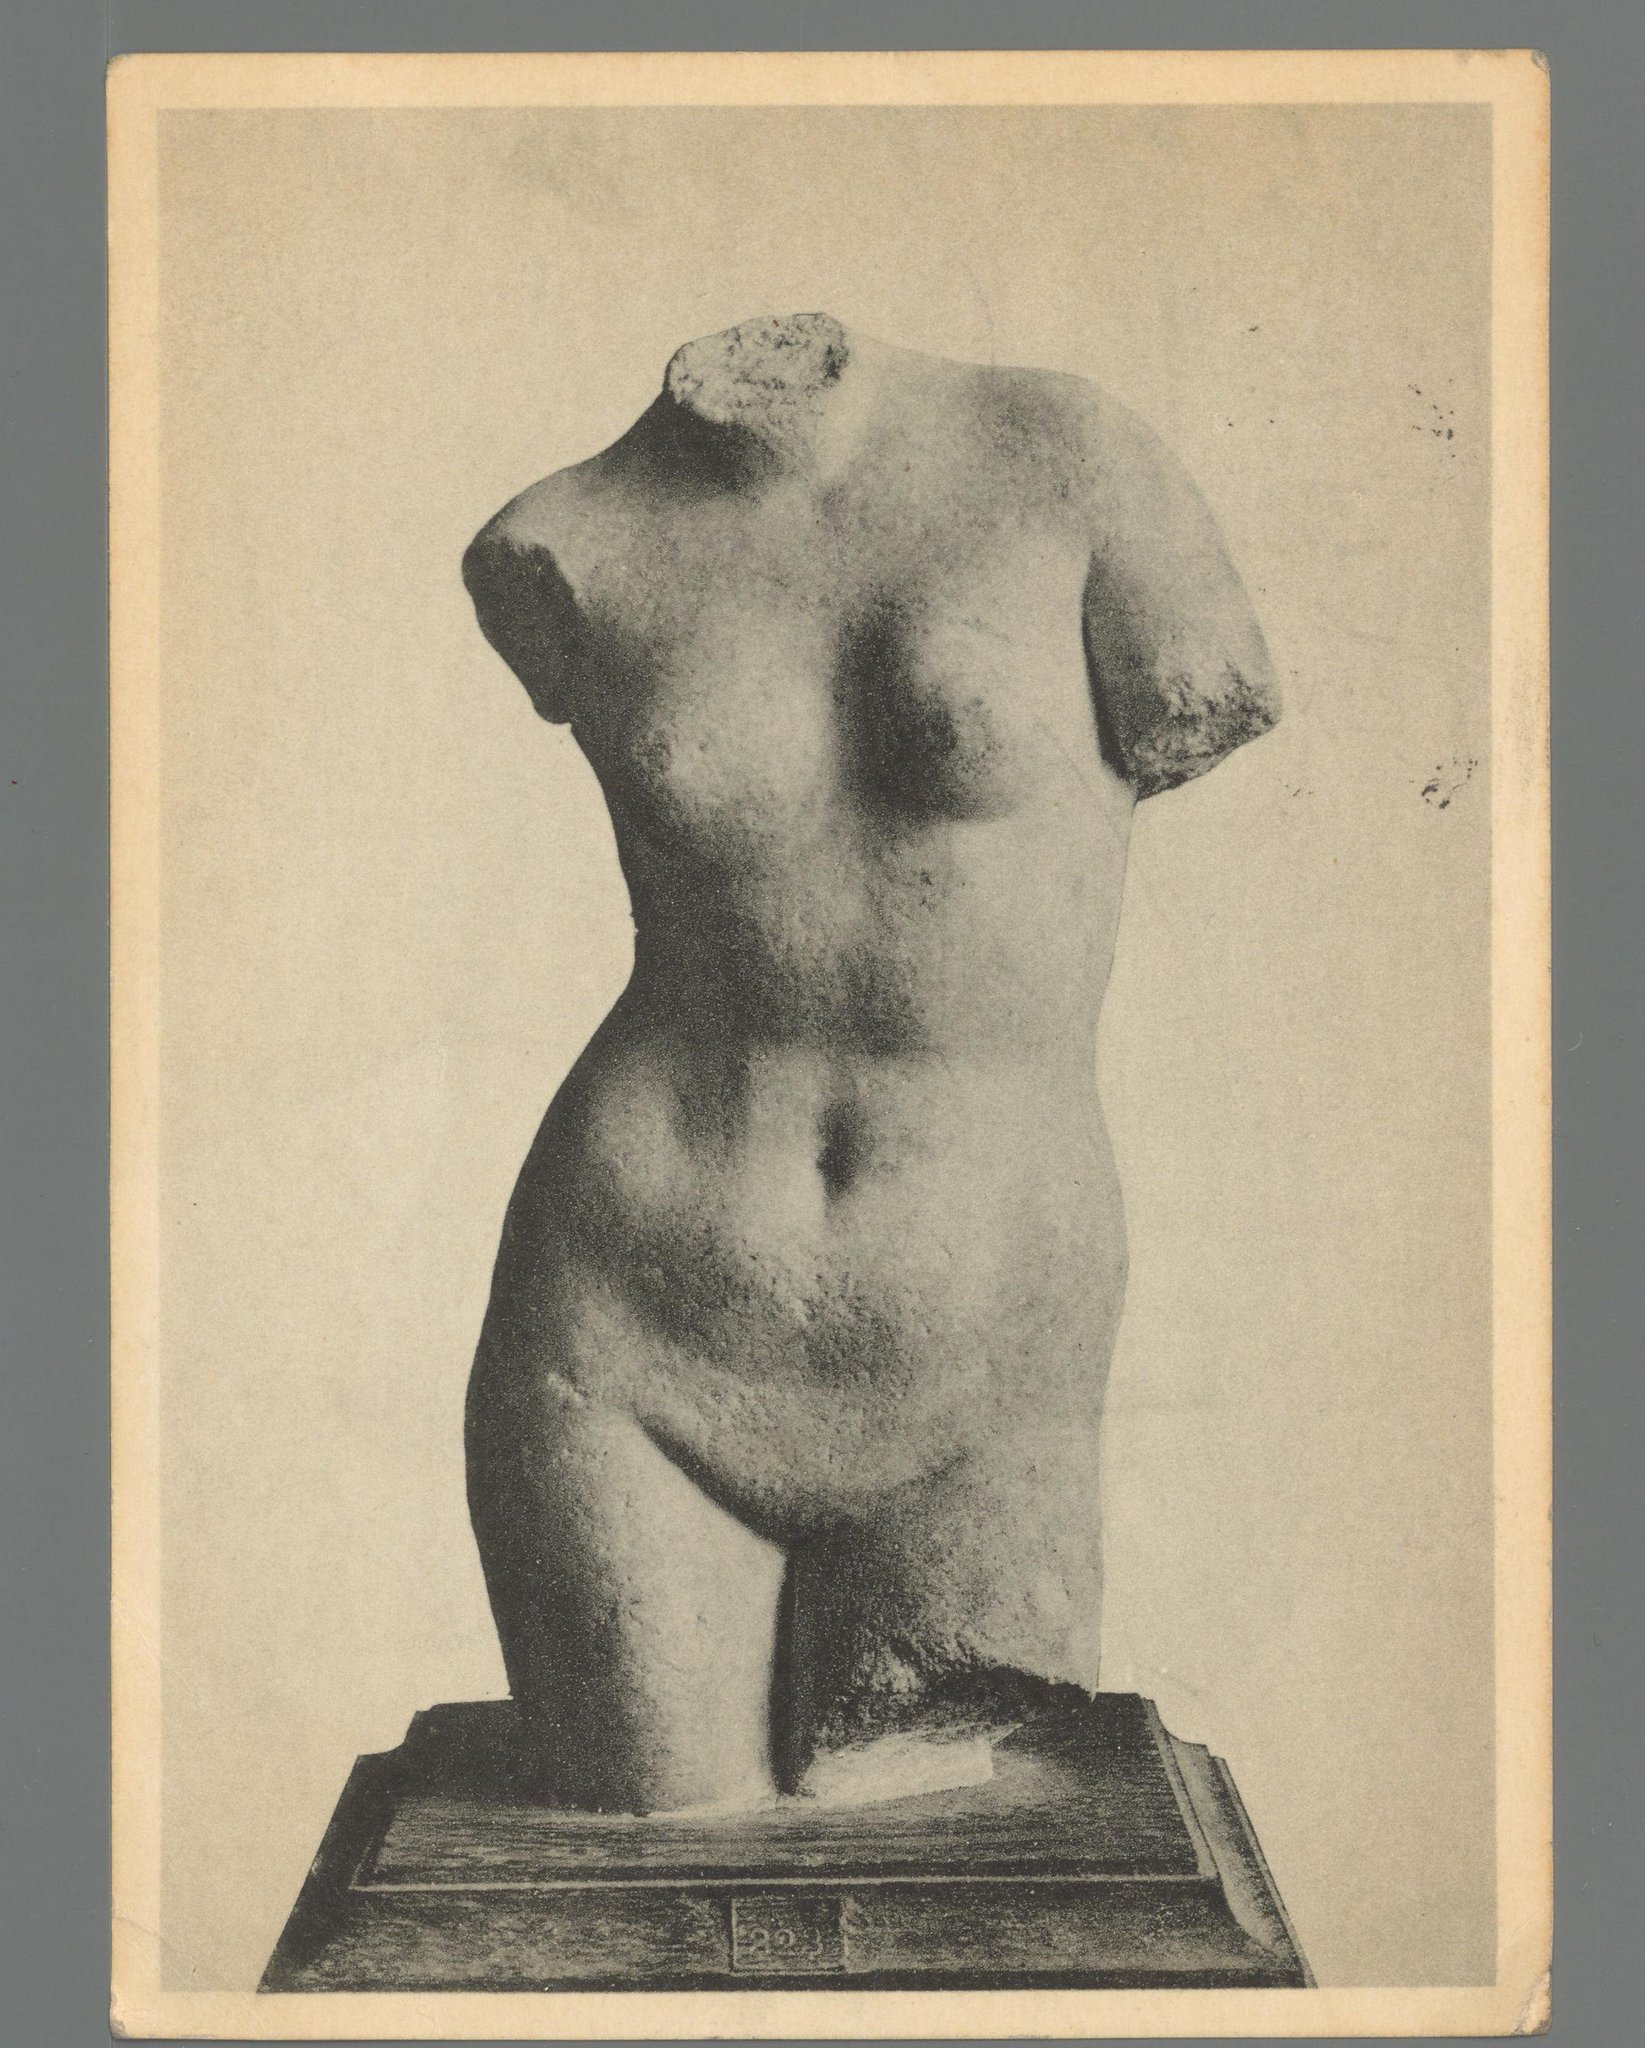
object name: photomechanical print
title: Musée de Mariemont. Torse d'Aphrodite. Epoque Hellénistique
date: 1917-1946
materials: cardboard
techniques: photograph, writing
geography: brussels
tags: statues, paintings, etc. ~ objects of worship in roman religion, permanent exhibition, museum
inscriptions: postage stamp